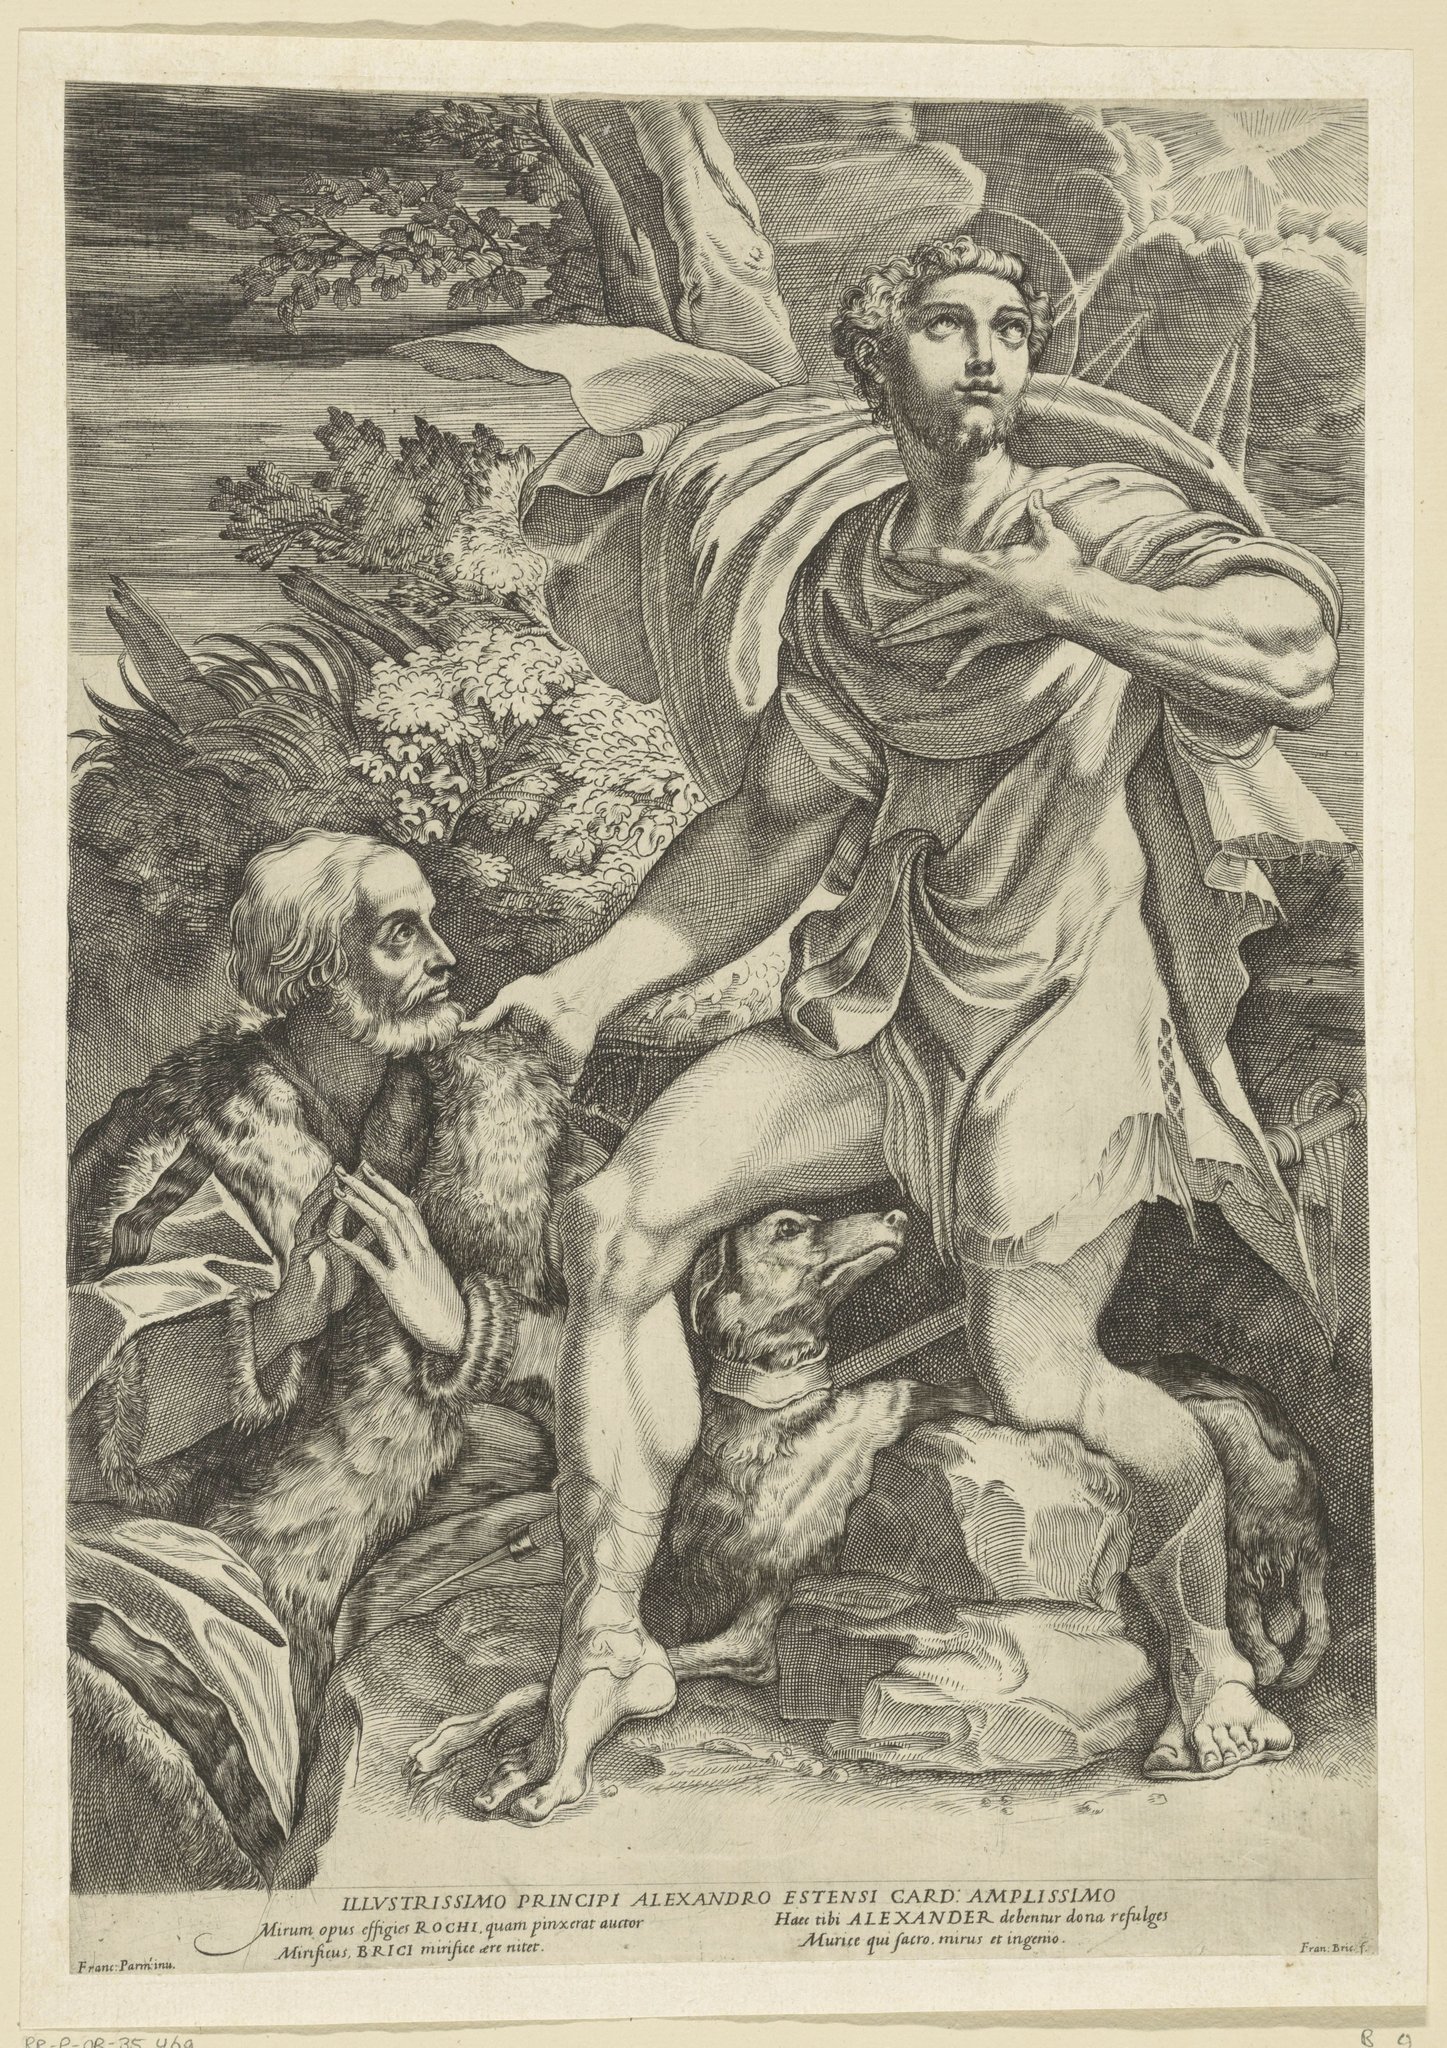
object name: print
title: Heilige Rochus smeekt bescherming van oudere edelman af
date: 1584-1623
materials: paper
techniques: engraving, etching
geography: italy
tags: the confessor and pilgrim roch(us) (rocco, rock) of montpellier; possible attributes: angel (with ointment box or spoon), dog (sometimes with loaf), (pointing at) plague-spot on thigh, pilgrim's shell, staff, hat and wallet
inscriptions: collector's mark: Lugt 240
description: De heilige Rochus leunt met een hand op de schouder van een oude edelman. Zijn andere hand houdt hij op zijn borst. Hij kijkt naar de hemel. Achter zijn benen ligt een hond.